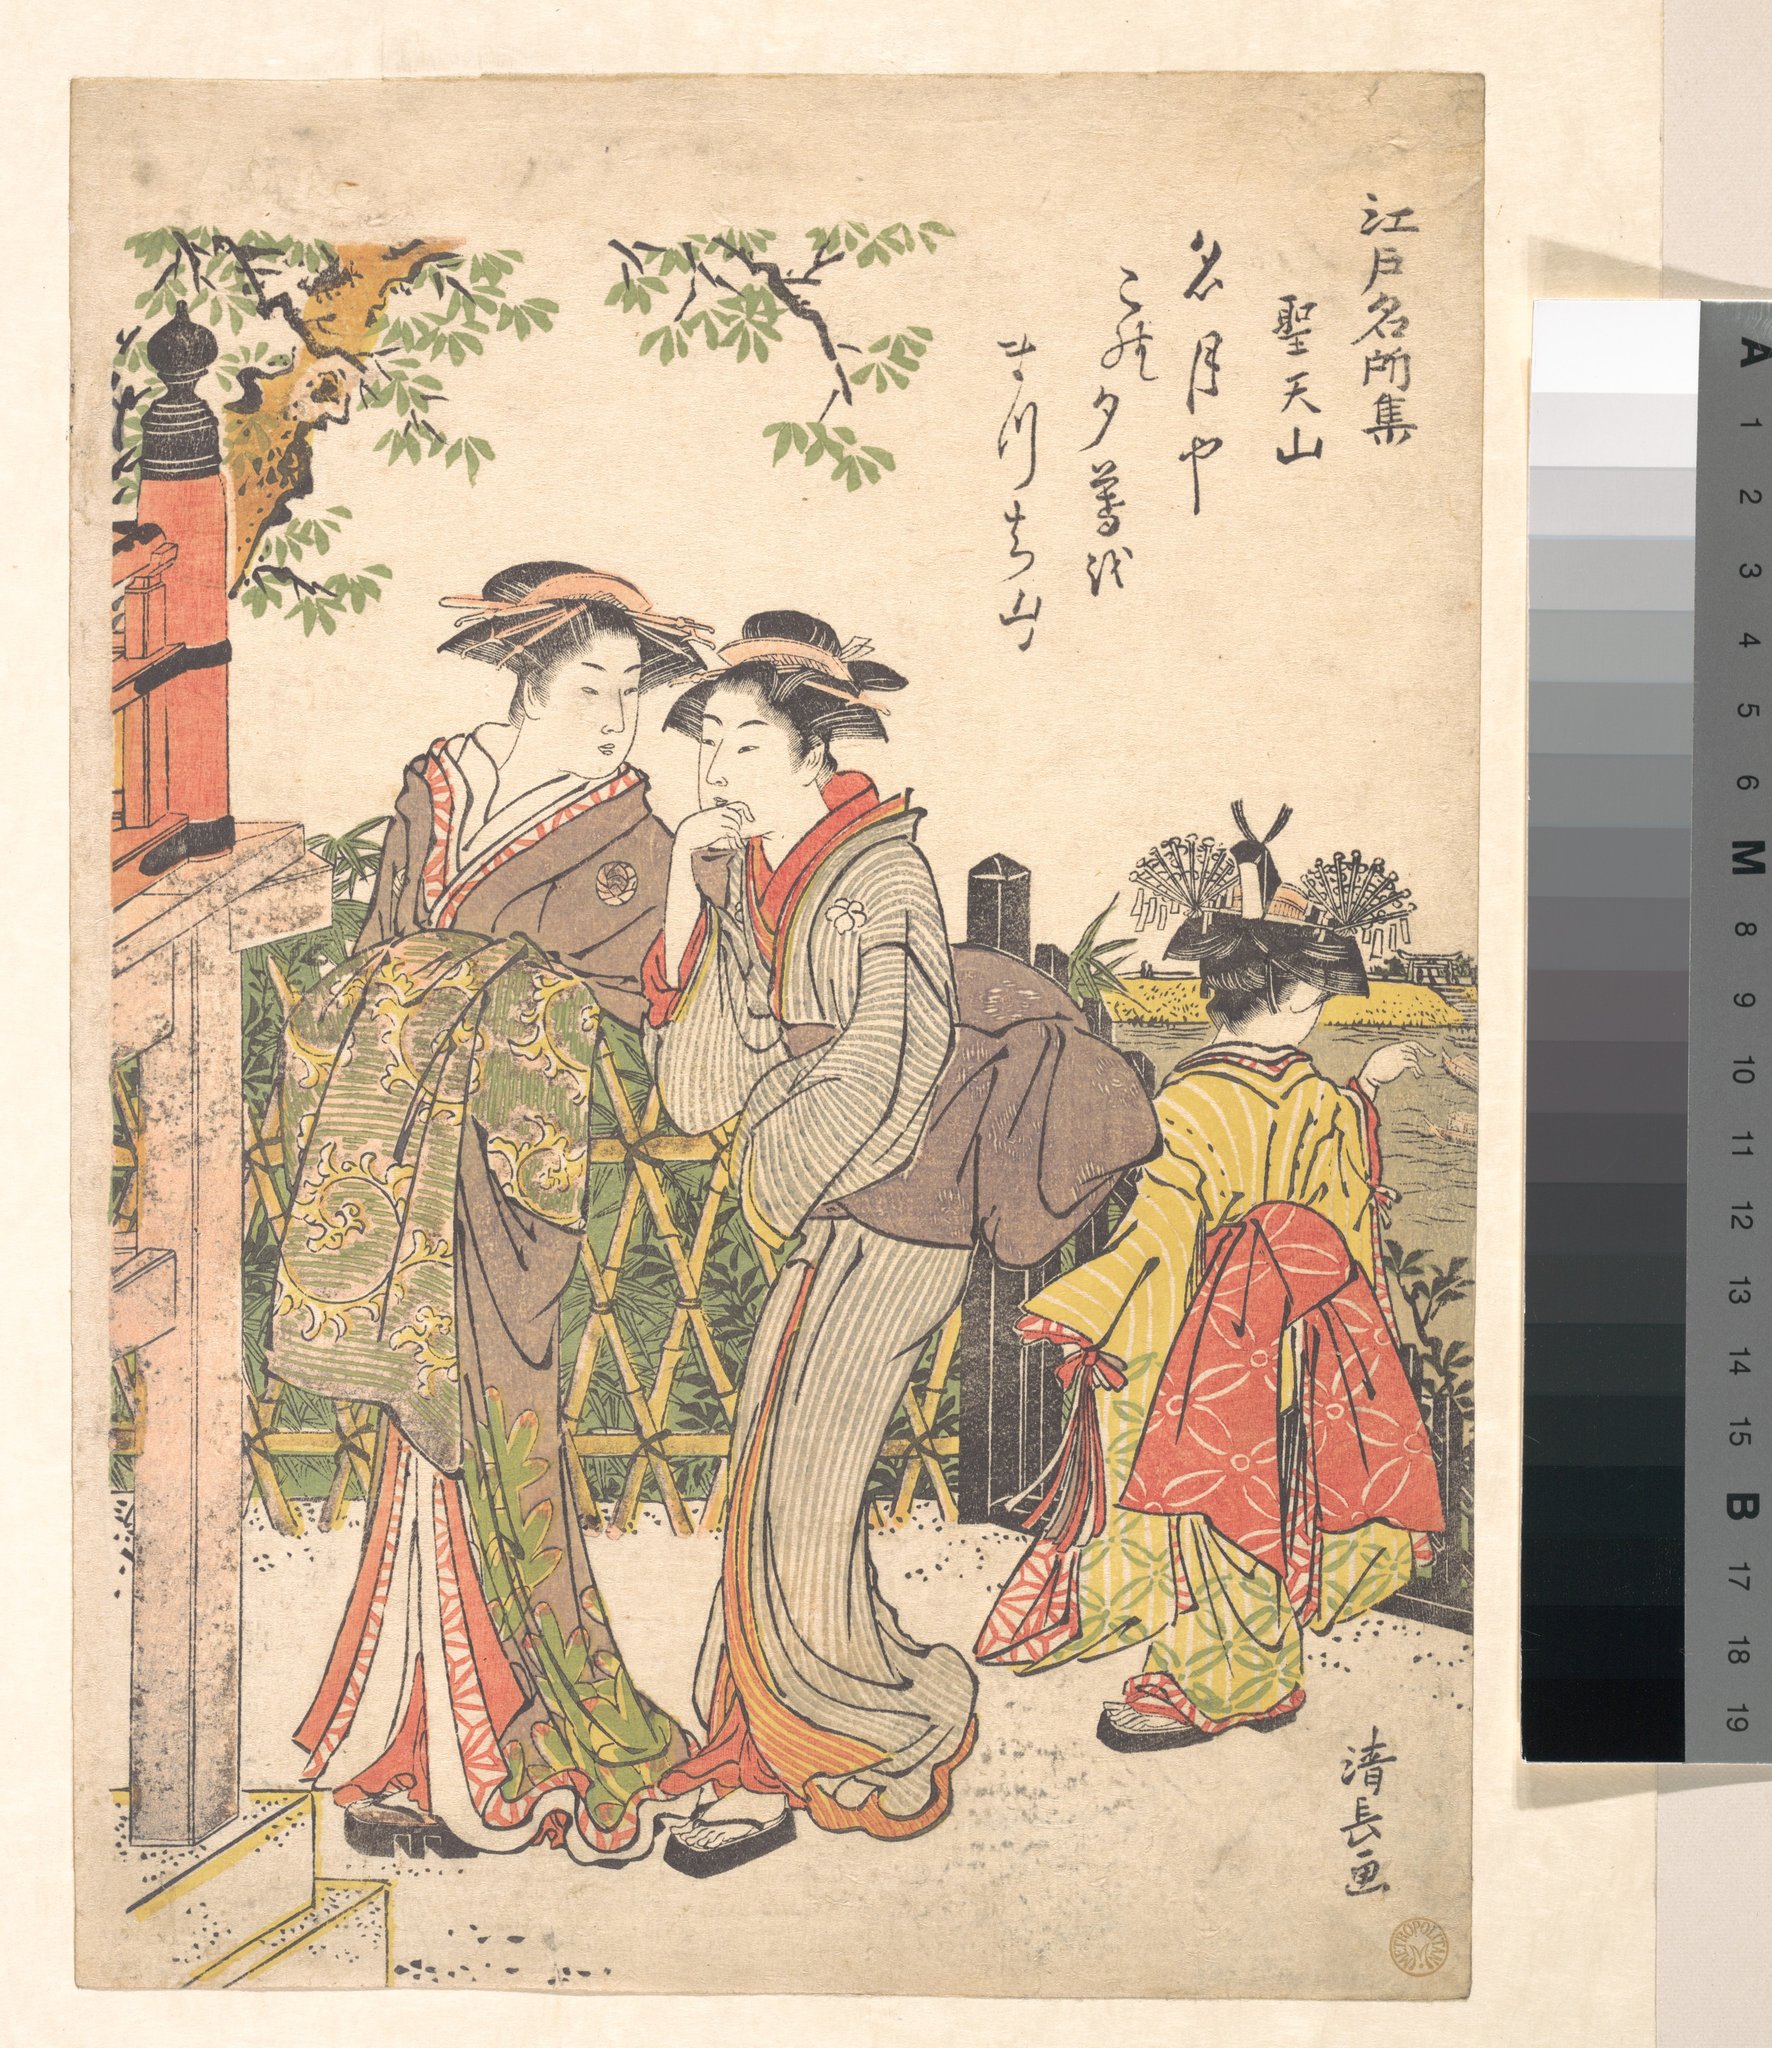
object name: print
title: Shōtenyama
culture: japanese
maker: torii kiyonaga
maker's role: artist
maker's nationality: japanese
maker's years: 1752-1815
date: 1779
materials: ink, paper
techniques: woodblock print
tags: women,trees